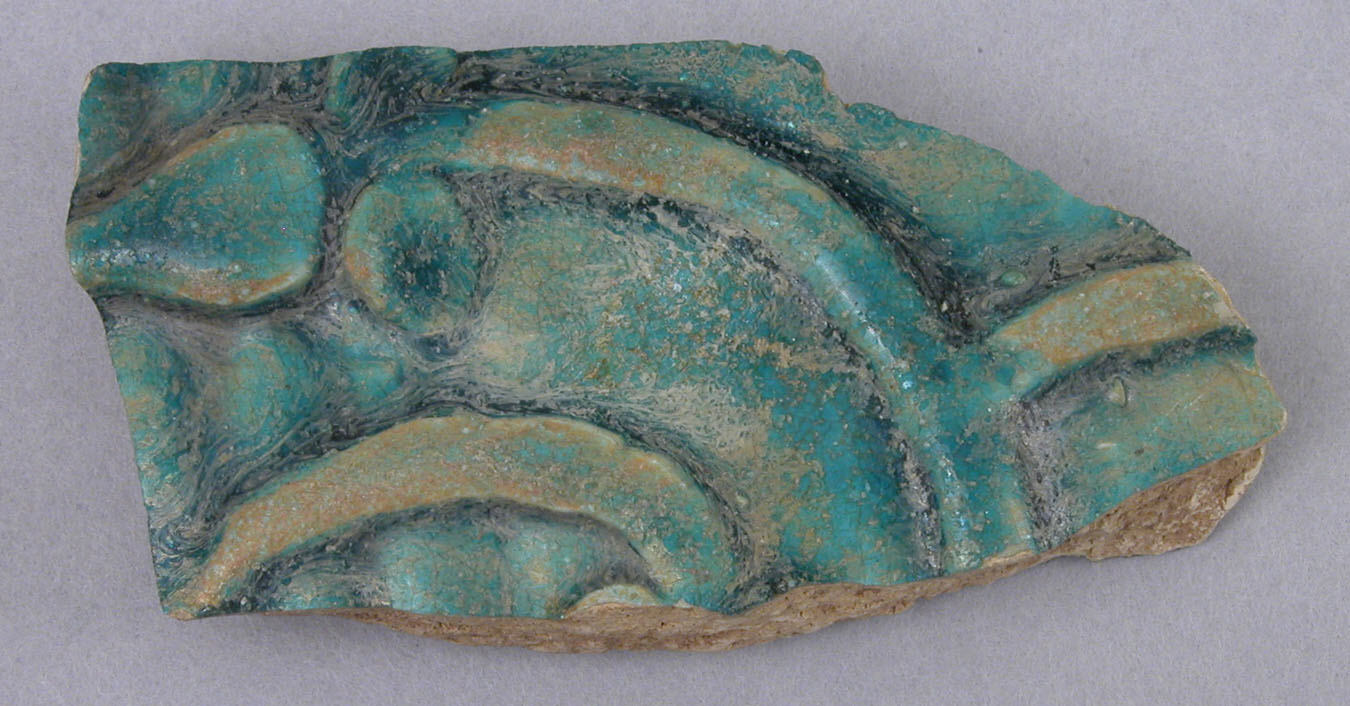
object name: fragment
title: Fragment of a Closed Vessel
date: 601-900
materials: earthenware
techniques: glazing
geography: iraq